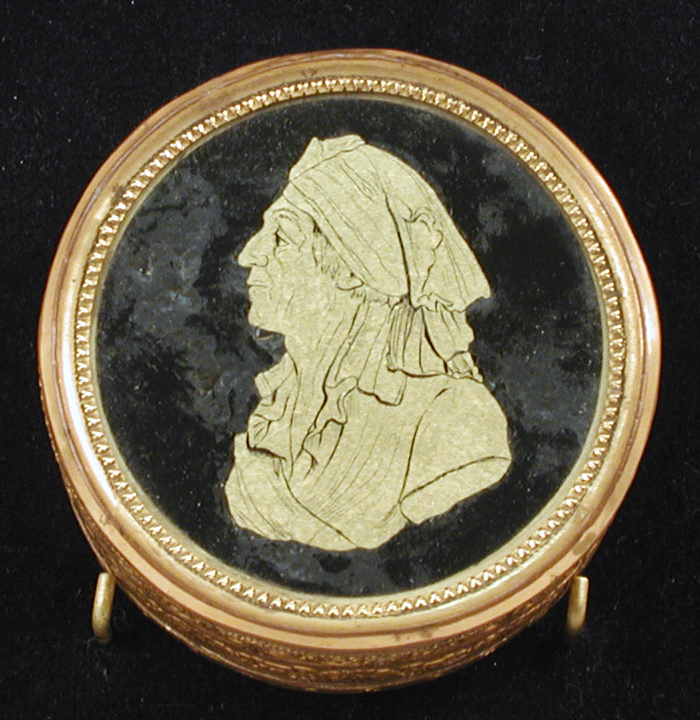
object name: box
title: Box with portrait of Jean Paul Marat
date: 1767-1800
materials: board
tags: men,profiles